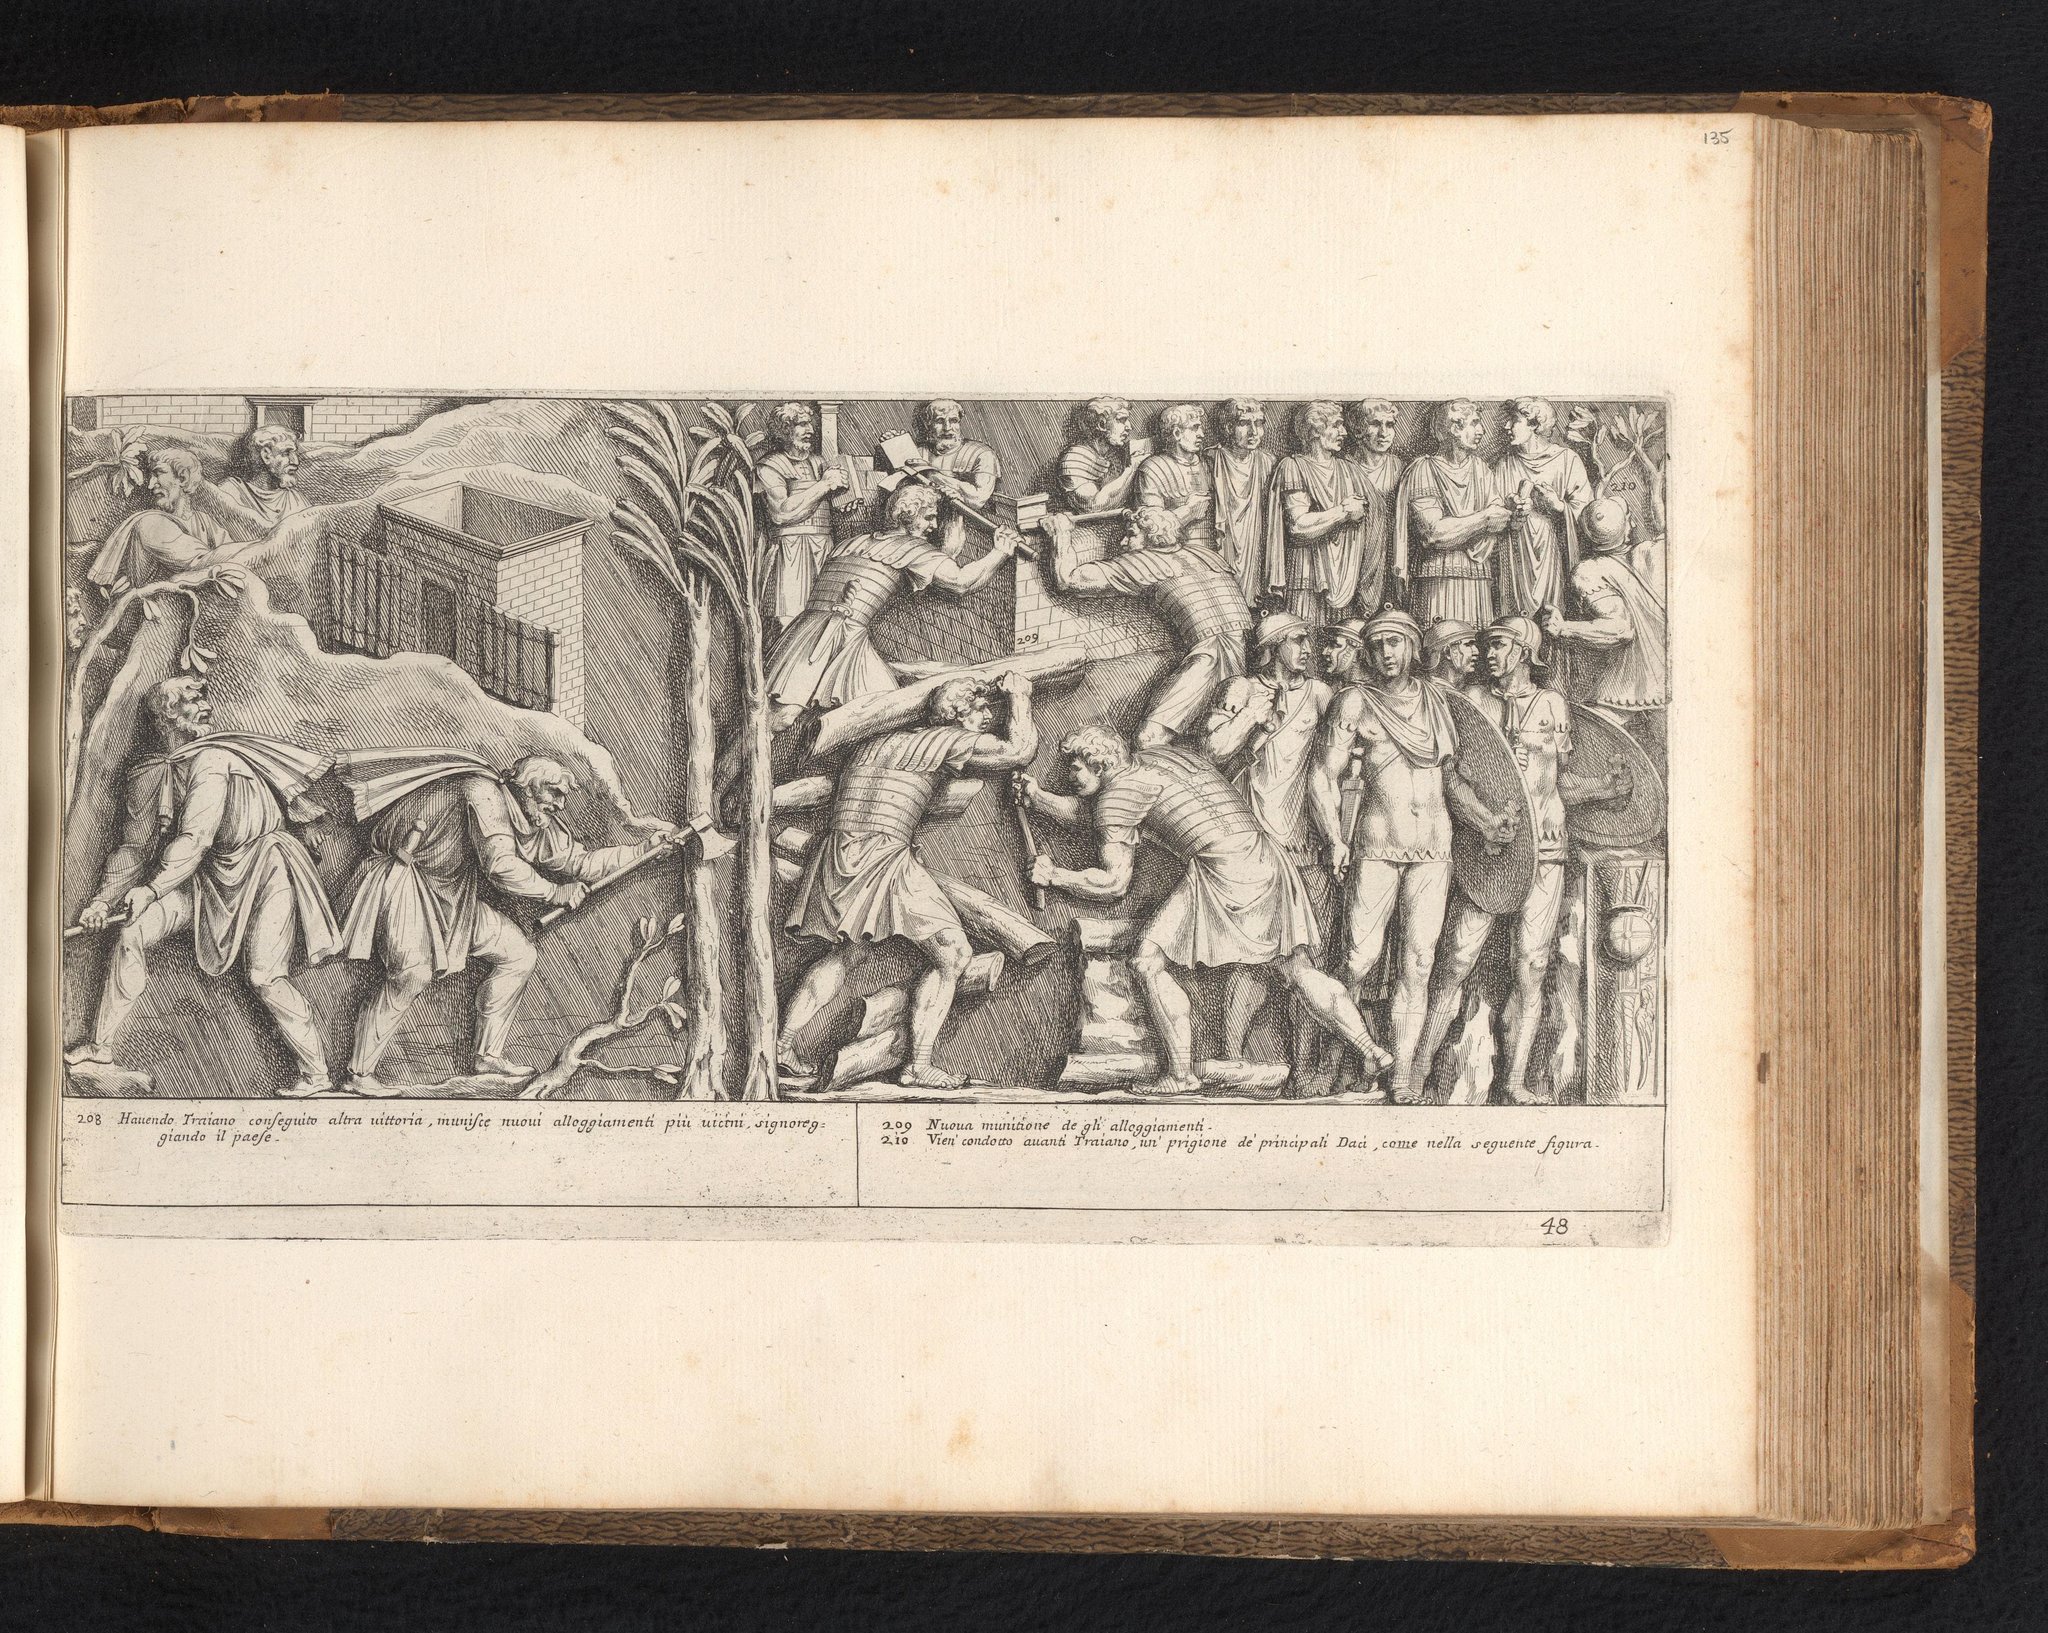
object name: album leaf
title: Detail van het fries op de Zuil van Trajanus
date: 1637-1691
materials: paper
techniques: etching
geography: rome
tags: triumphal column with helical friezes, piece of sculpture, reproduction of a piece of sculpture, the soldier; the soldier's life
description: Detail van het spiraalvormige gebeeldhouwde fries op de Zuil van Trajanus. Het fries toont de oorlogen tussen de Romeinen en de Daciërs. Verklarende nummers in de ondermarge. Prent maakt deel uit van een album.